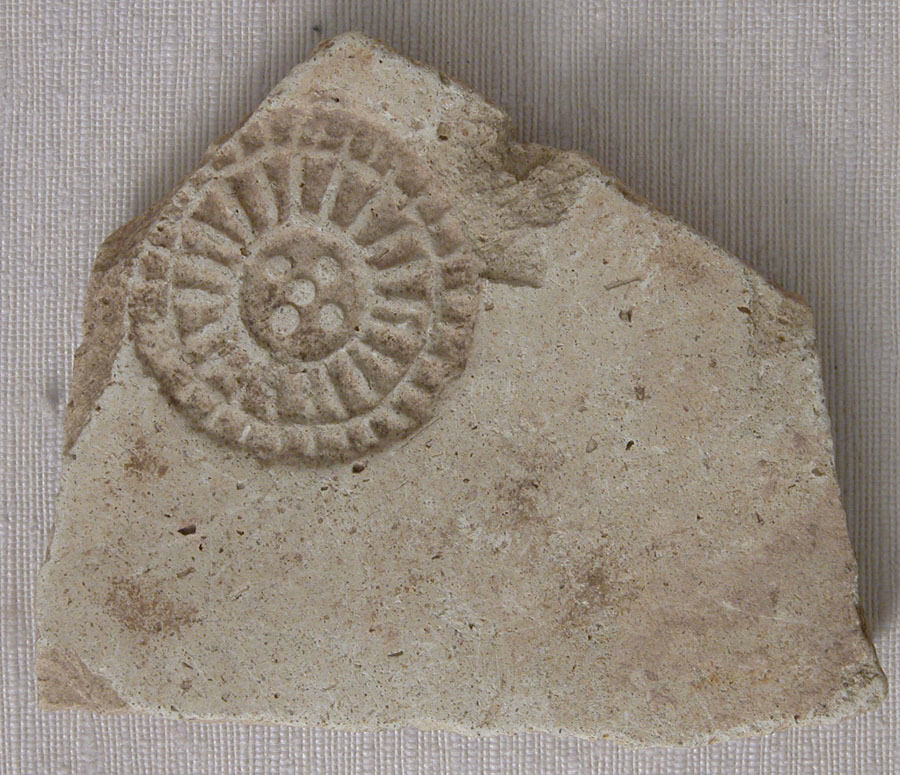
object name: fragment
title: Ceramic Fragment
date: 201-700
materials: earthenware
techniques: stamping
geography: iraq